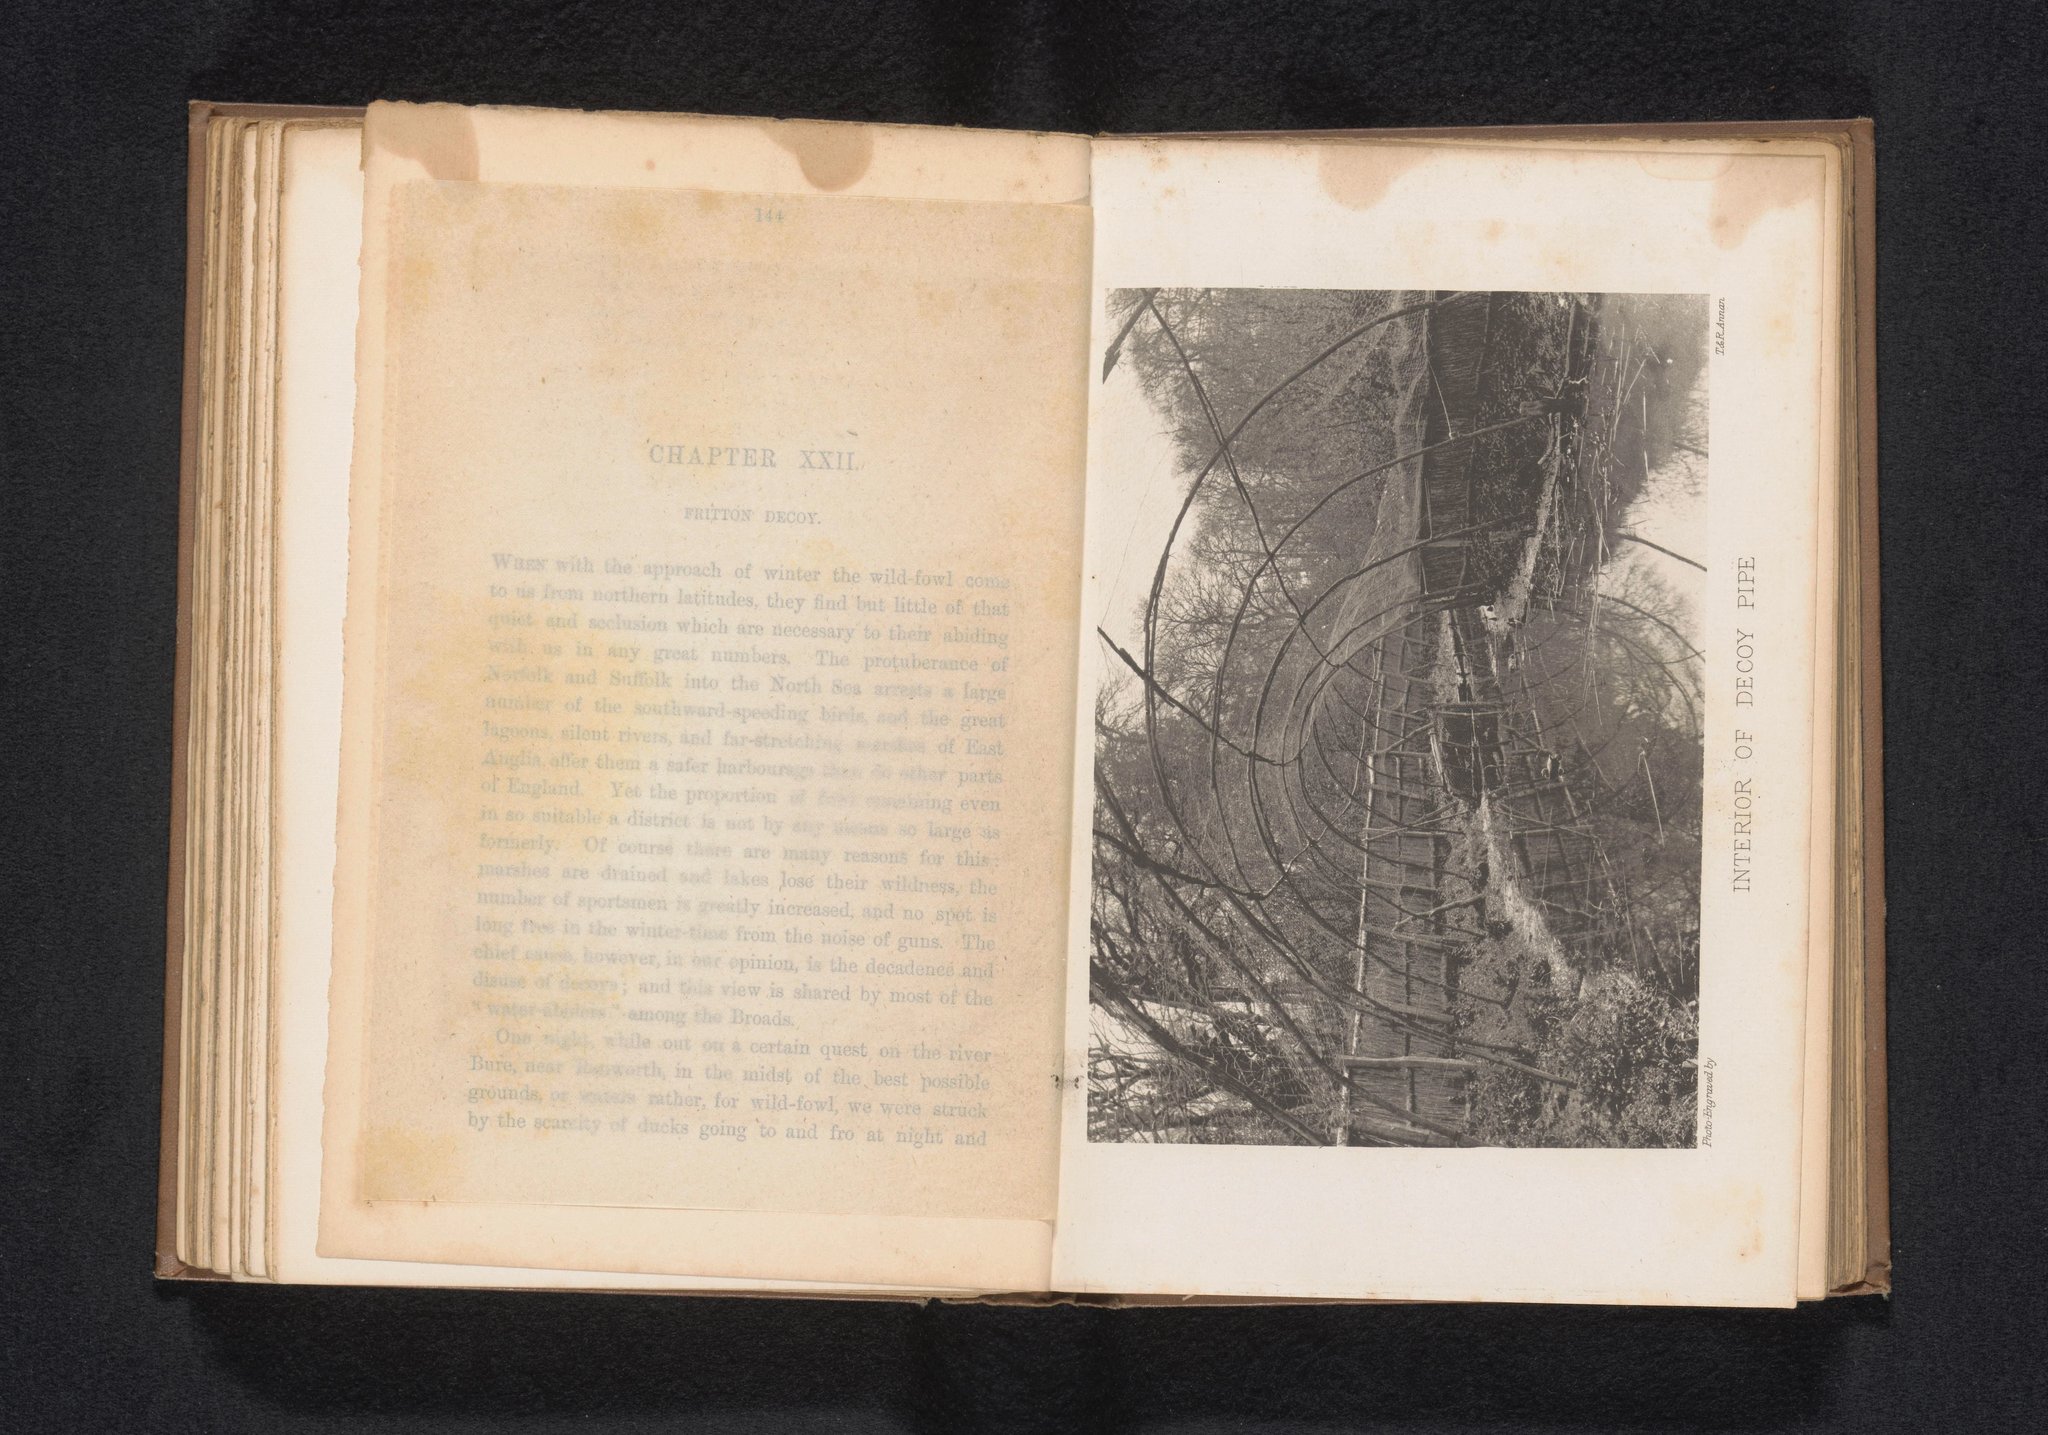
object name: photomechanical print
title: Interior of decoy pipe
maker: george christopher davies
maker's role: fotograaf, geoloog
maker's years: 1849-1922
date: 1878-1883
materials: paper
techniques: photoaquatint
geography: fritton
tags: duck decoy